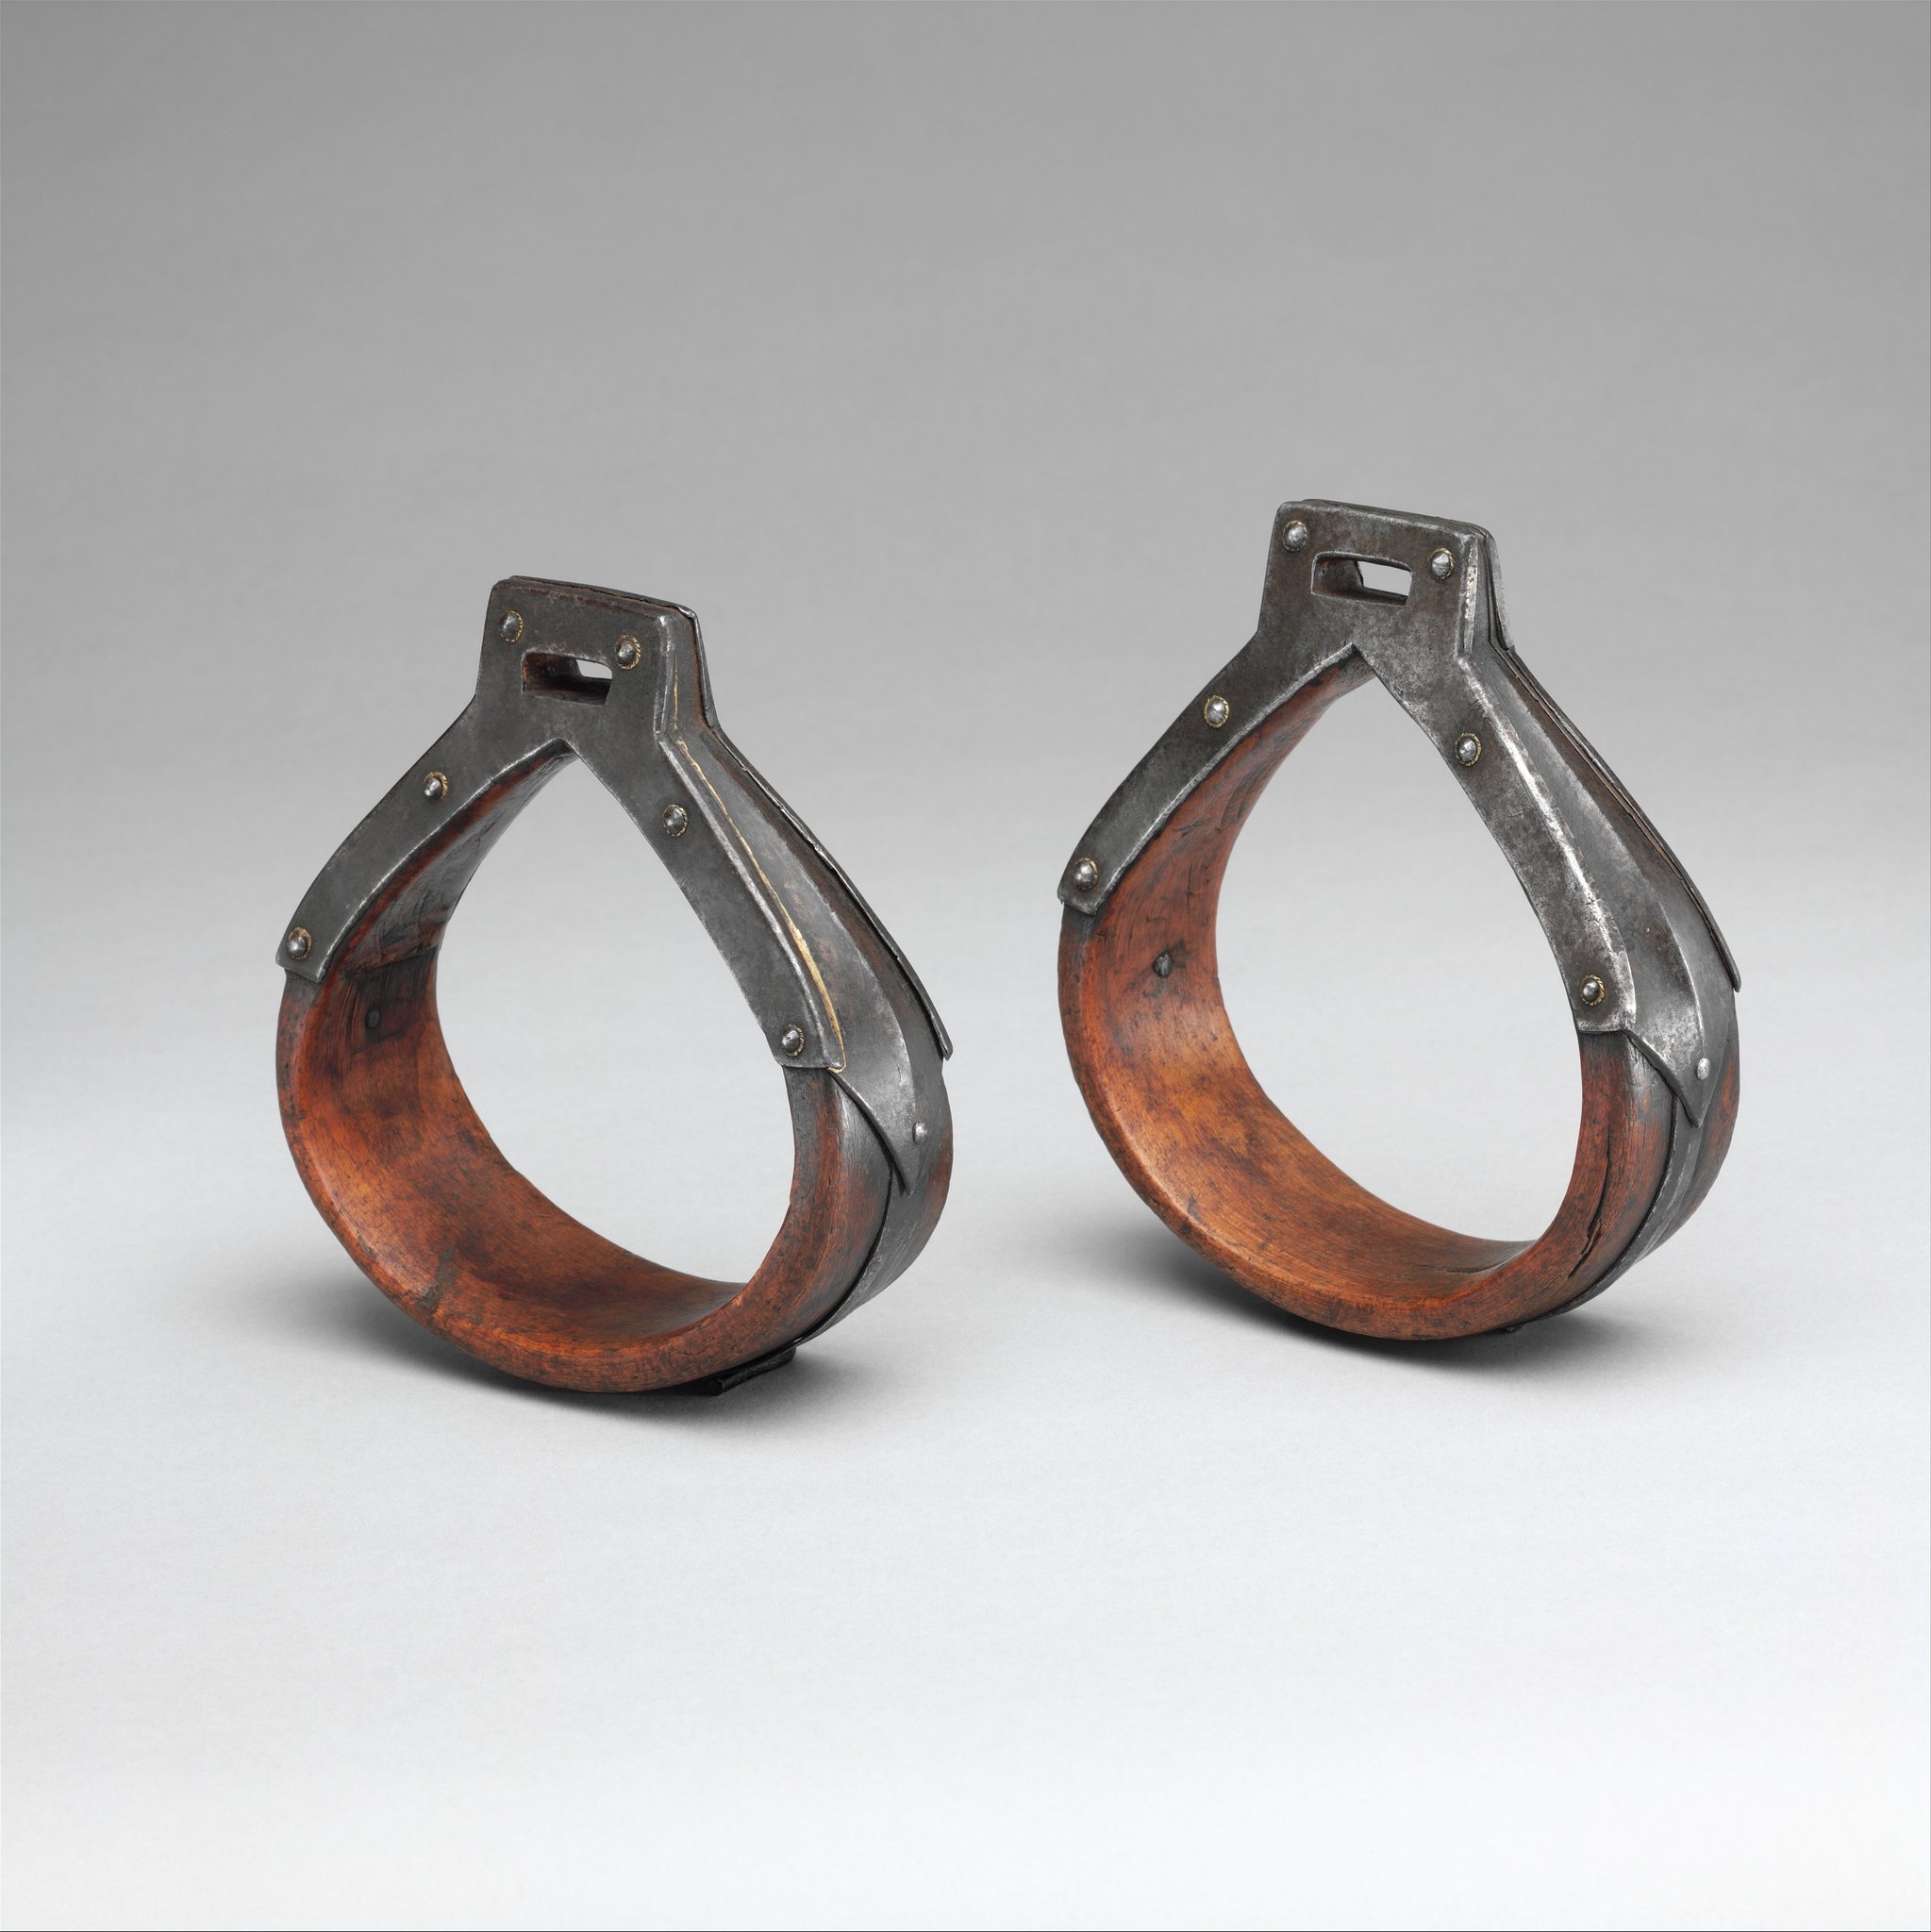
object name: pair of stirrrups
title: Pair of Stirrups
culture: mongolian or tibetan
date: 1501-1900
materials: copper alloy, iron, wood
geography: mongolia